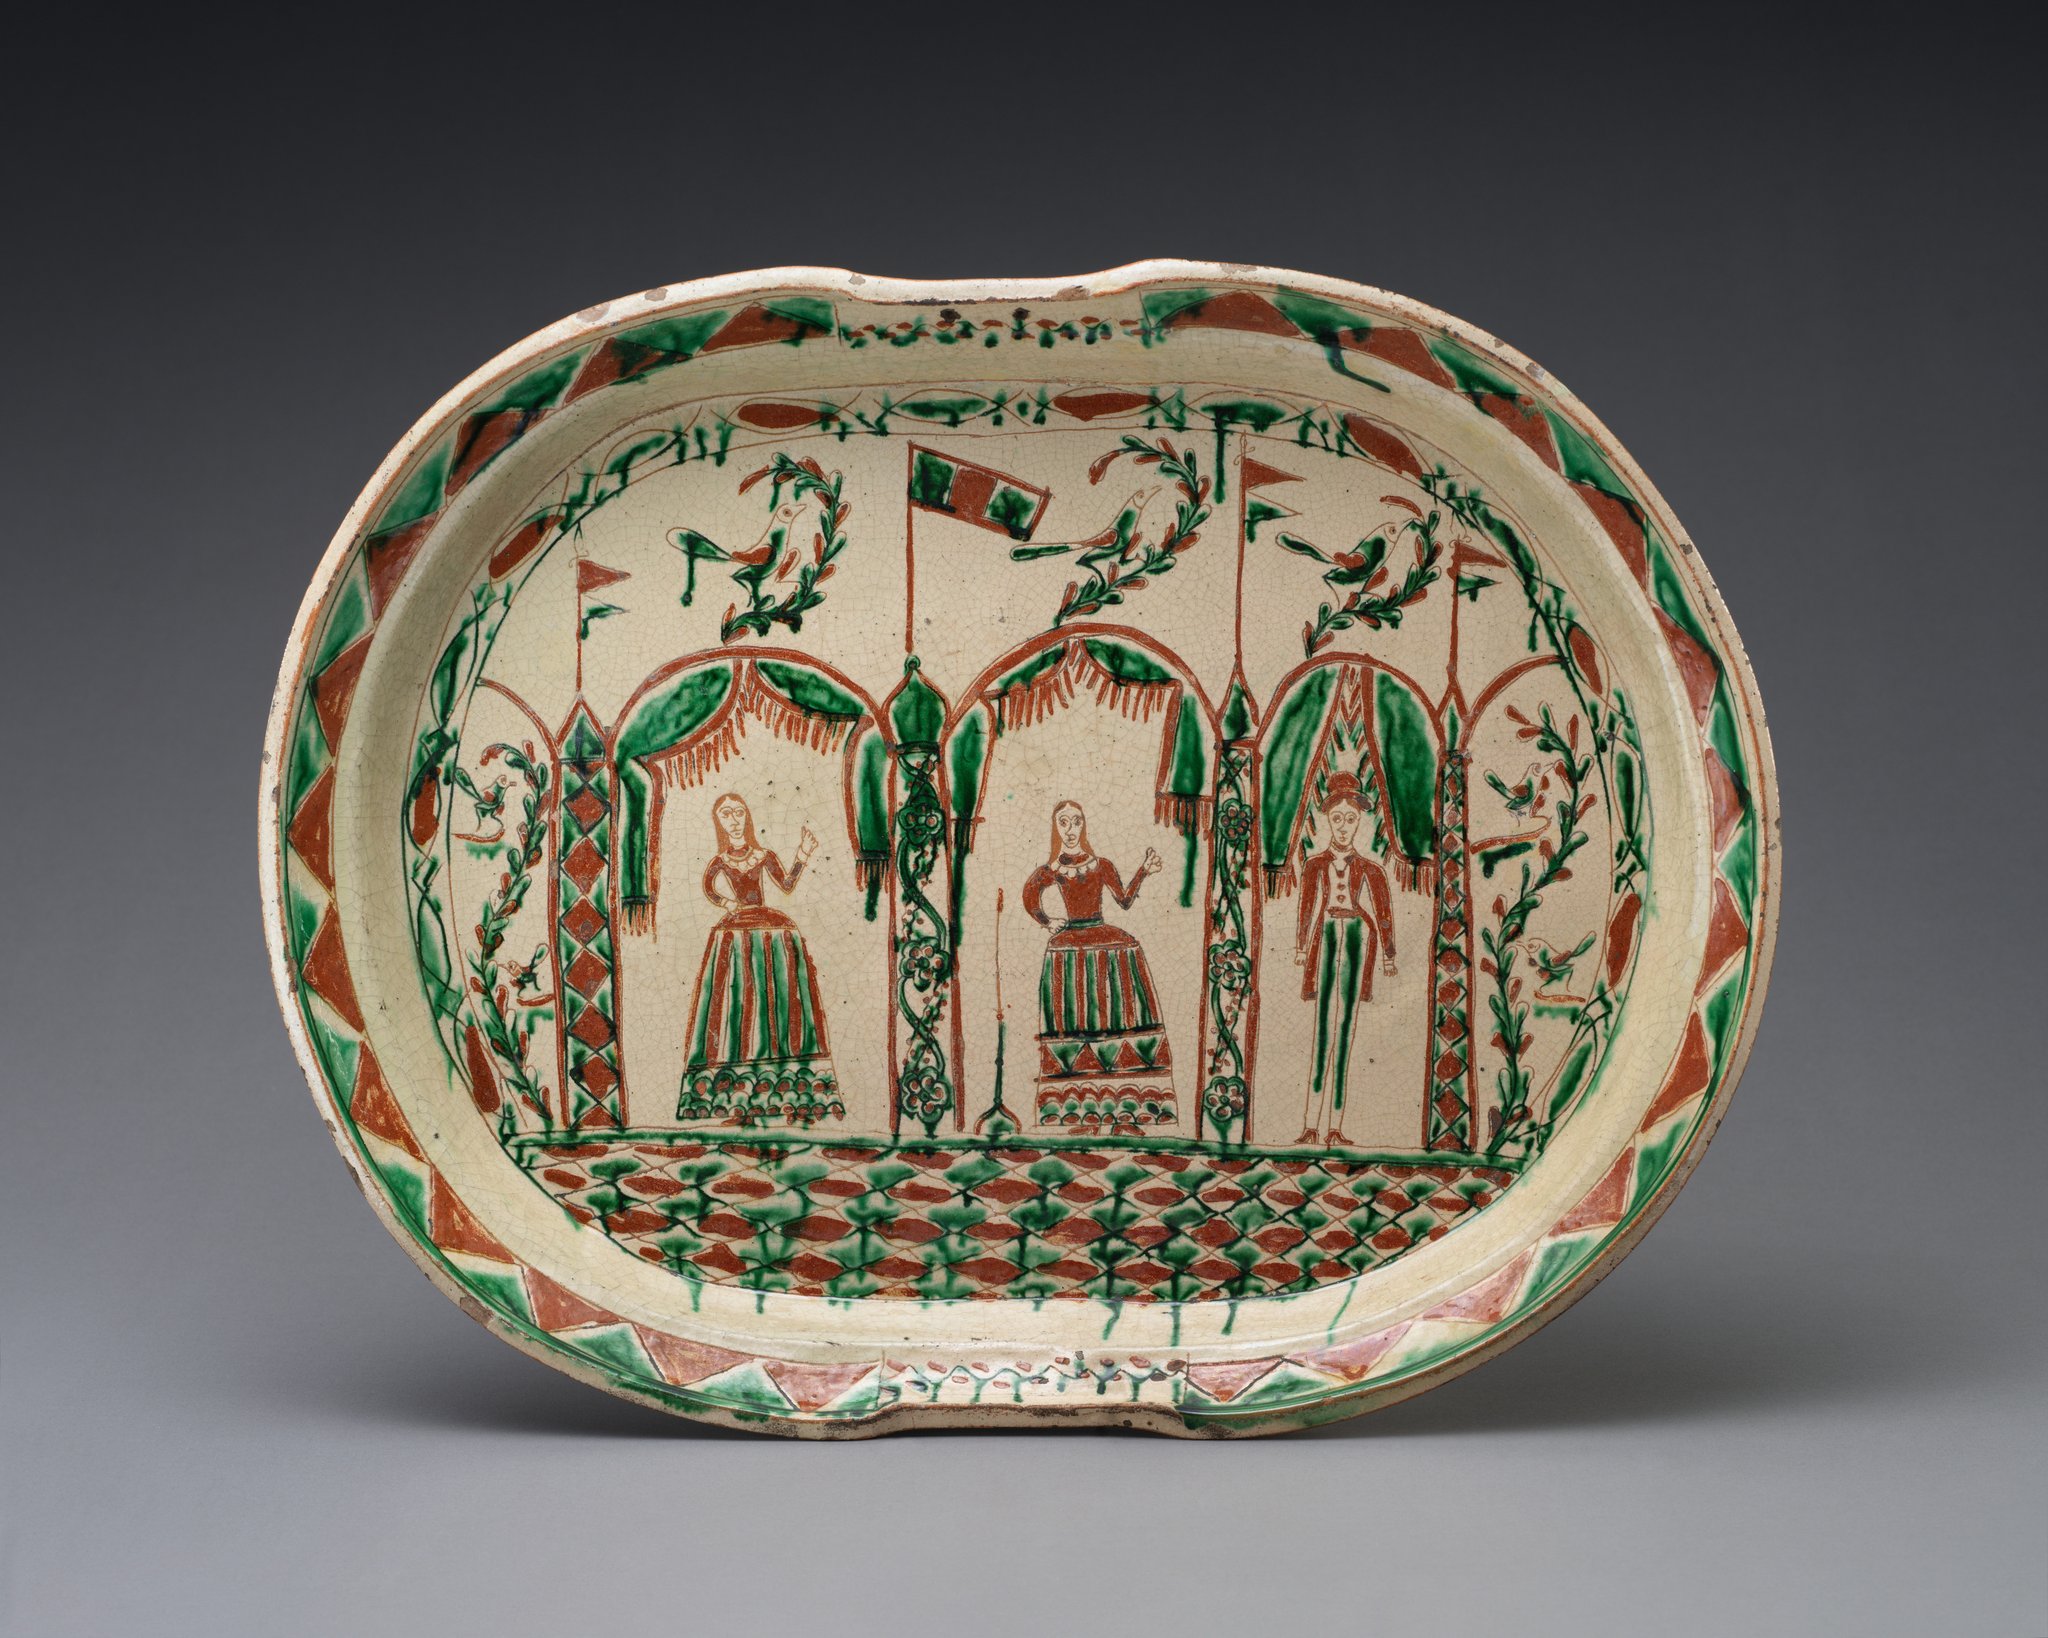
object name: dish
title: Dish (Charola)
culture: mexican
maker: Anonymous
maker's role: artist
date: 1820-1840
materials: earthenware, glaze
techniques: incising, polychrome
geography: mexico